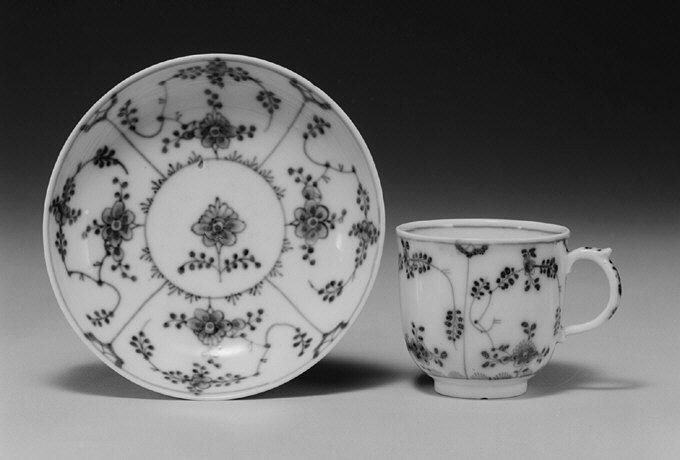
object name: cup and saucer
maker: zurich pottery and porcelain factory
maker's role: factory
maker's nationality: swiss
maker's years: 1763-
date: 1775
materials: hard paste porcelain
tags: flowers